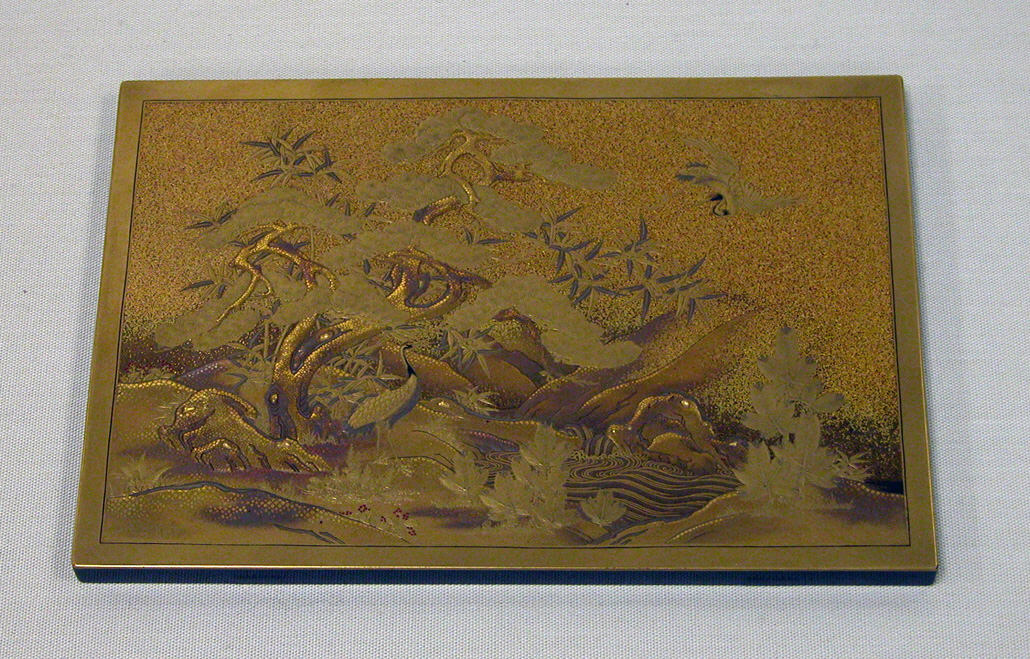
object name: panel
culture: japanese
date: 1601-1700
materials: gold, lacquer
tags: birds,leaves,trees